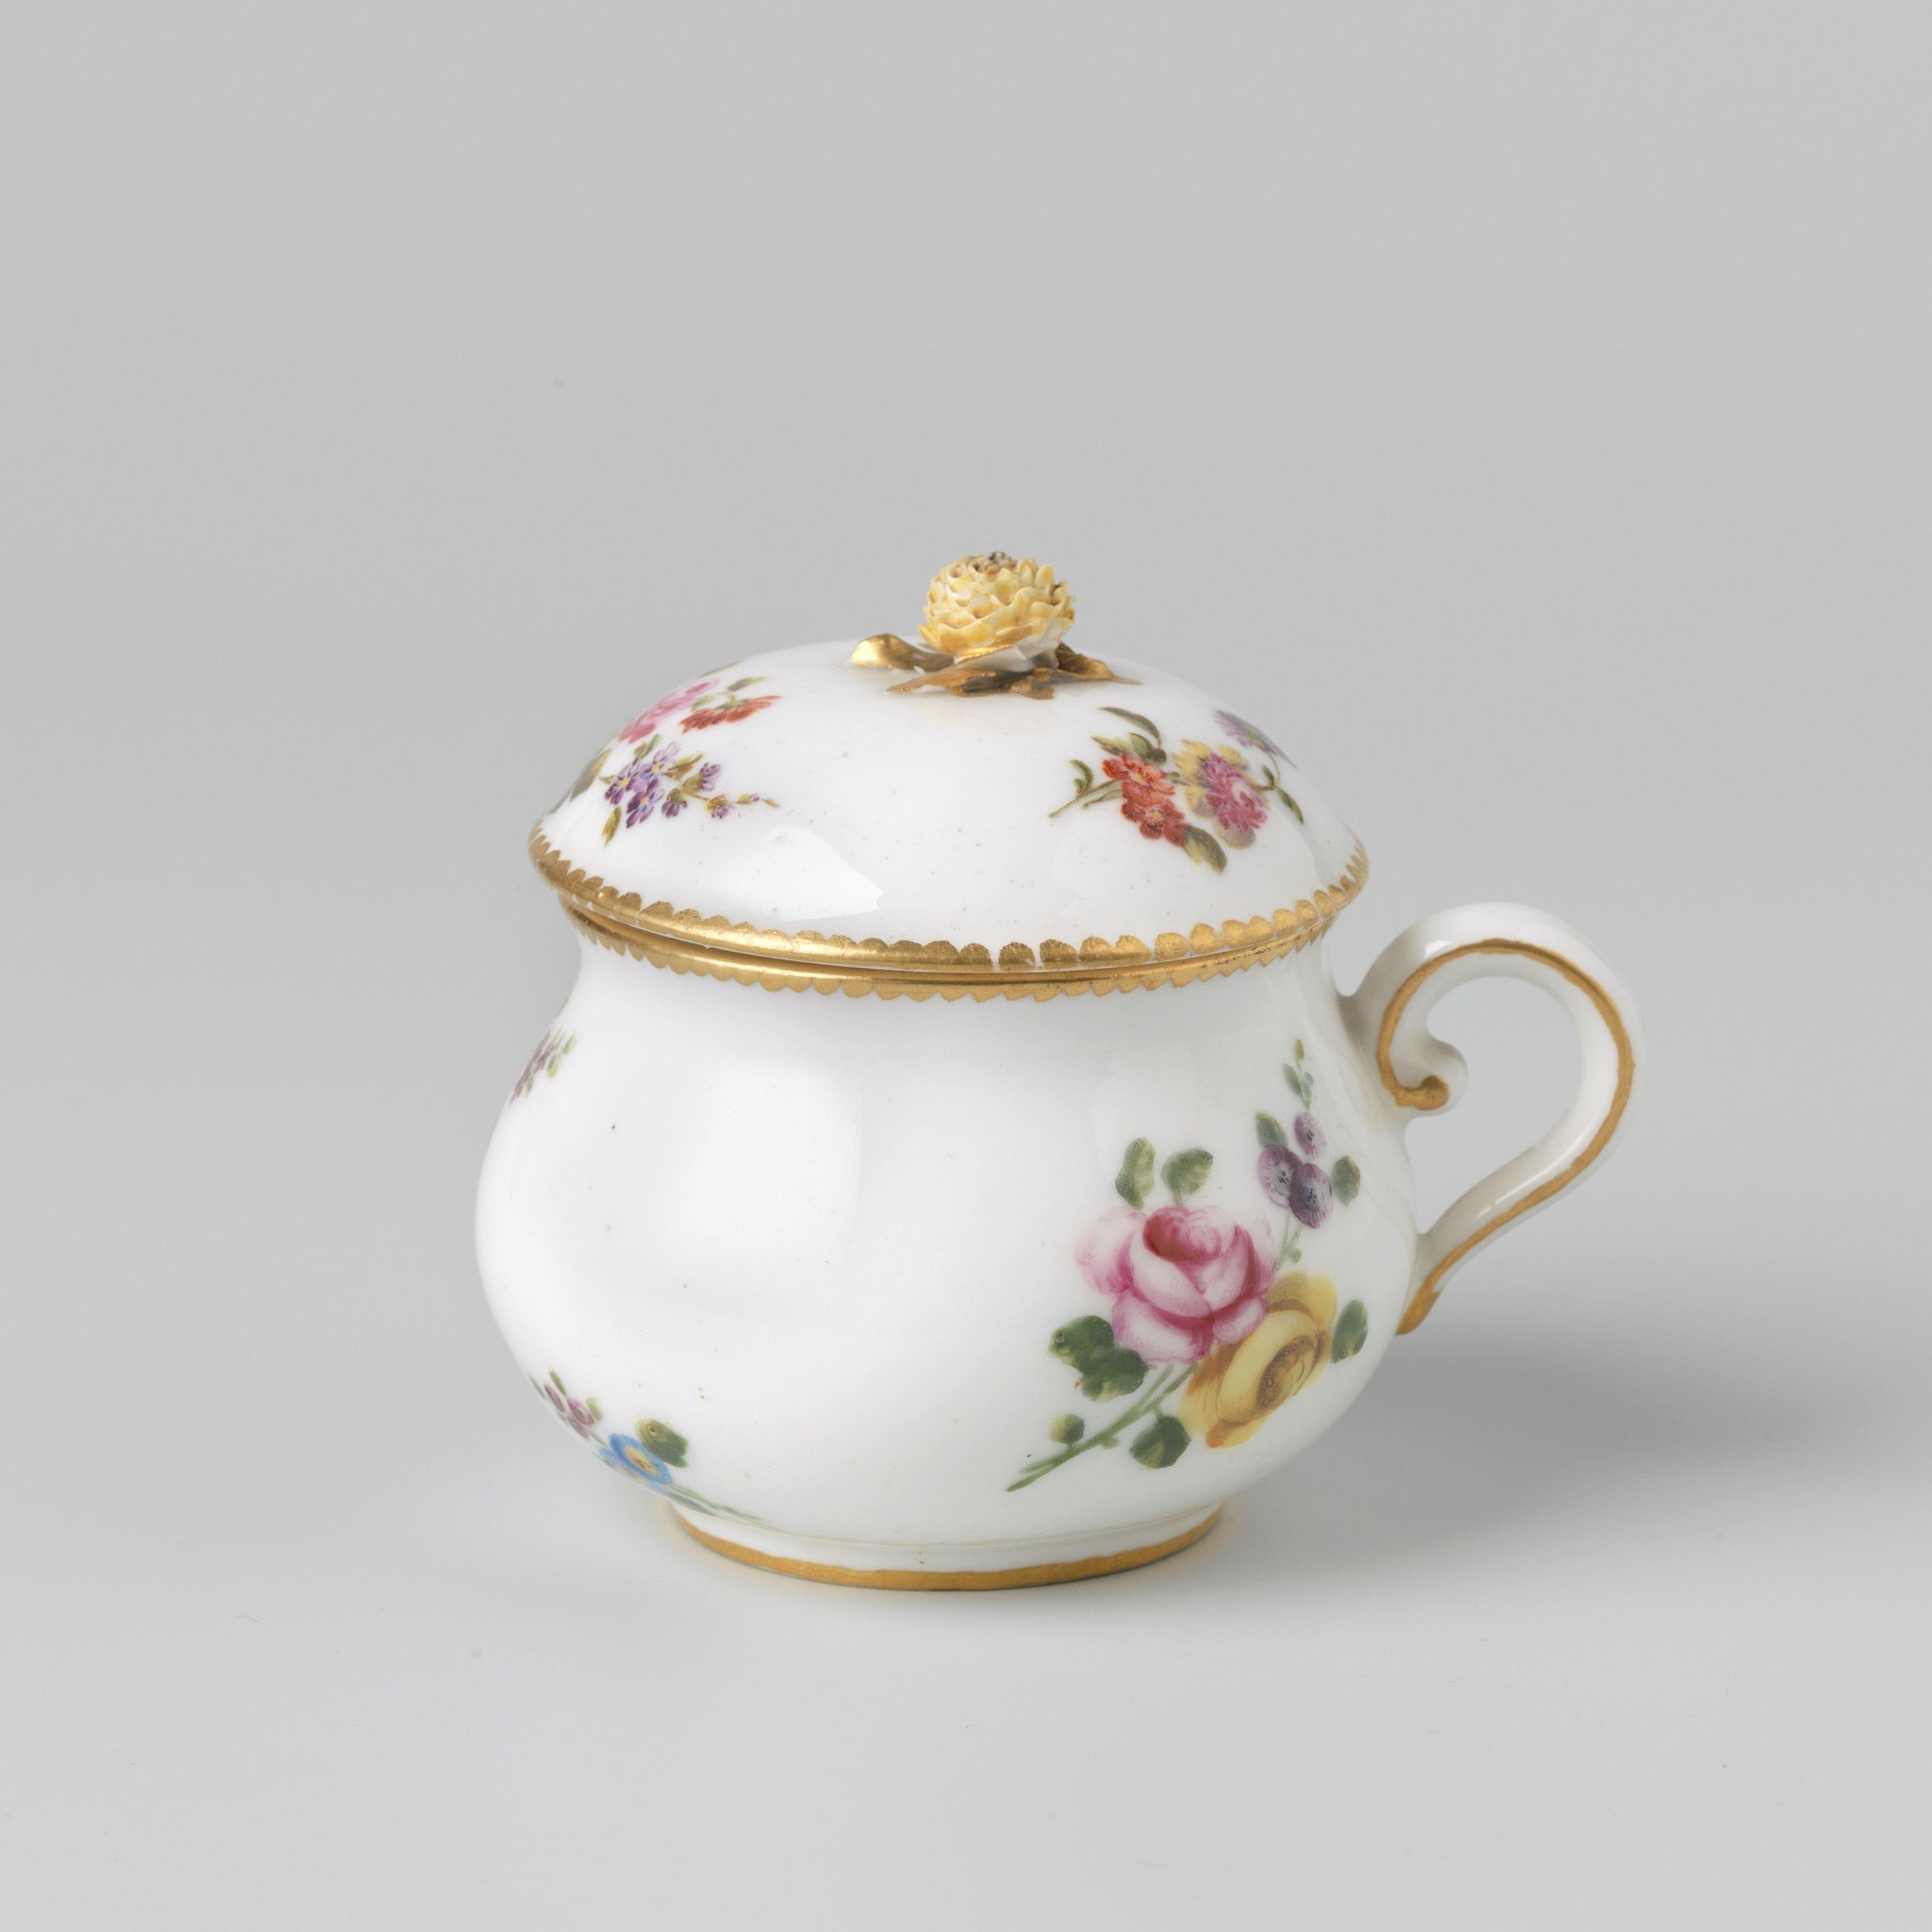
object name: covered jar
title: Covered pot with bouquets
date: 1760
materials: glaze, gold, paint, porcelain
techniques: firing, forming, gilding, turning, vitrification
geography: sèvres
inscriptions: mark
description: Dekselpot (roompot) van porselein met een gedrukt peervormig lichaam en gekruld oor, beschilderd op het glazuur in blauw, rood, roze, groen, geel, paars, zwart en goud. De buik is versierd met verschillende boeketten. Gouden lijn op de voet en de zijkant van het oor. Op de nek een decoratieve band in goud. Gemerkt op de onderzijde met de dubbele L met jaarletter G, waaronder een krul.